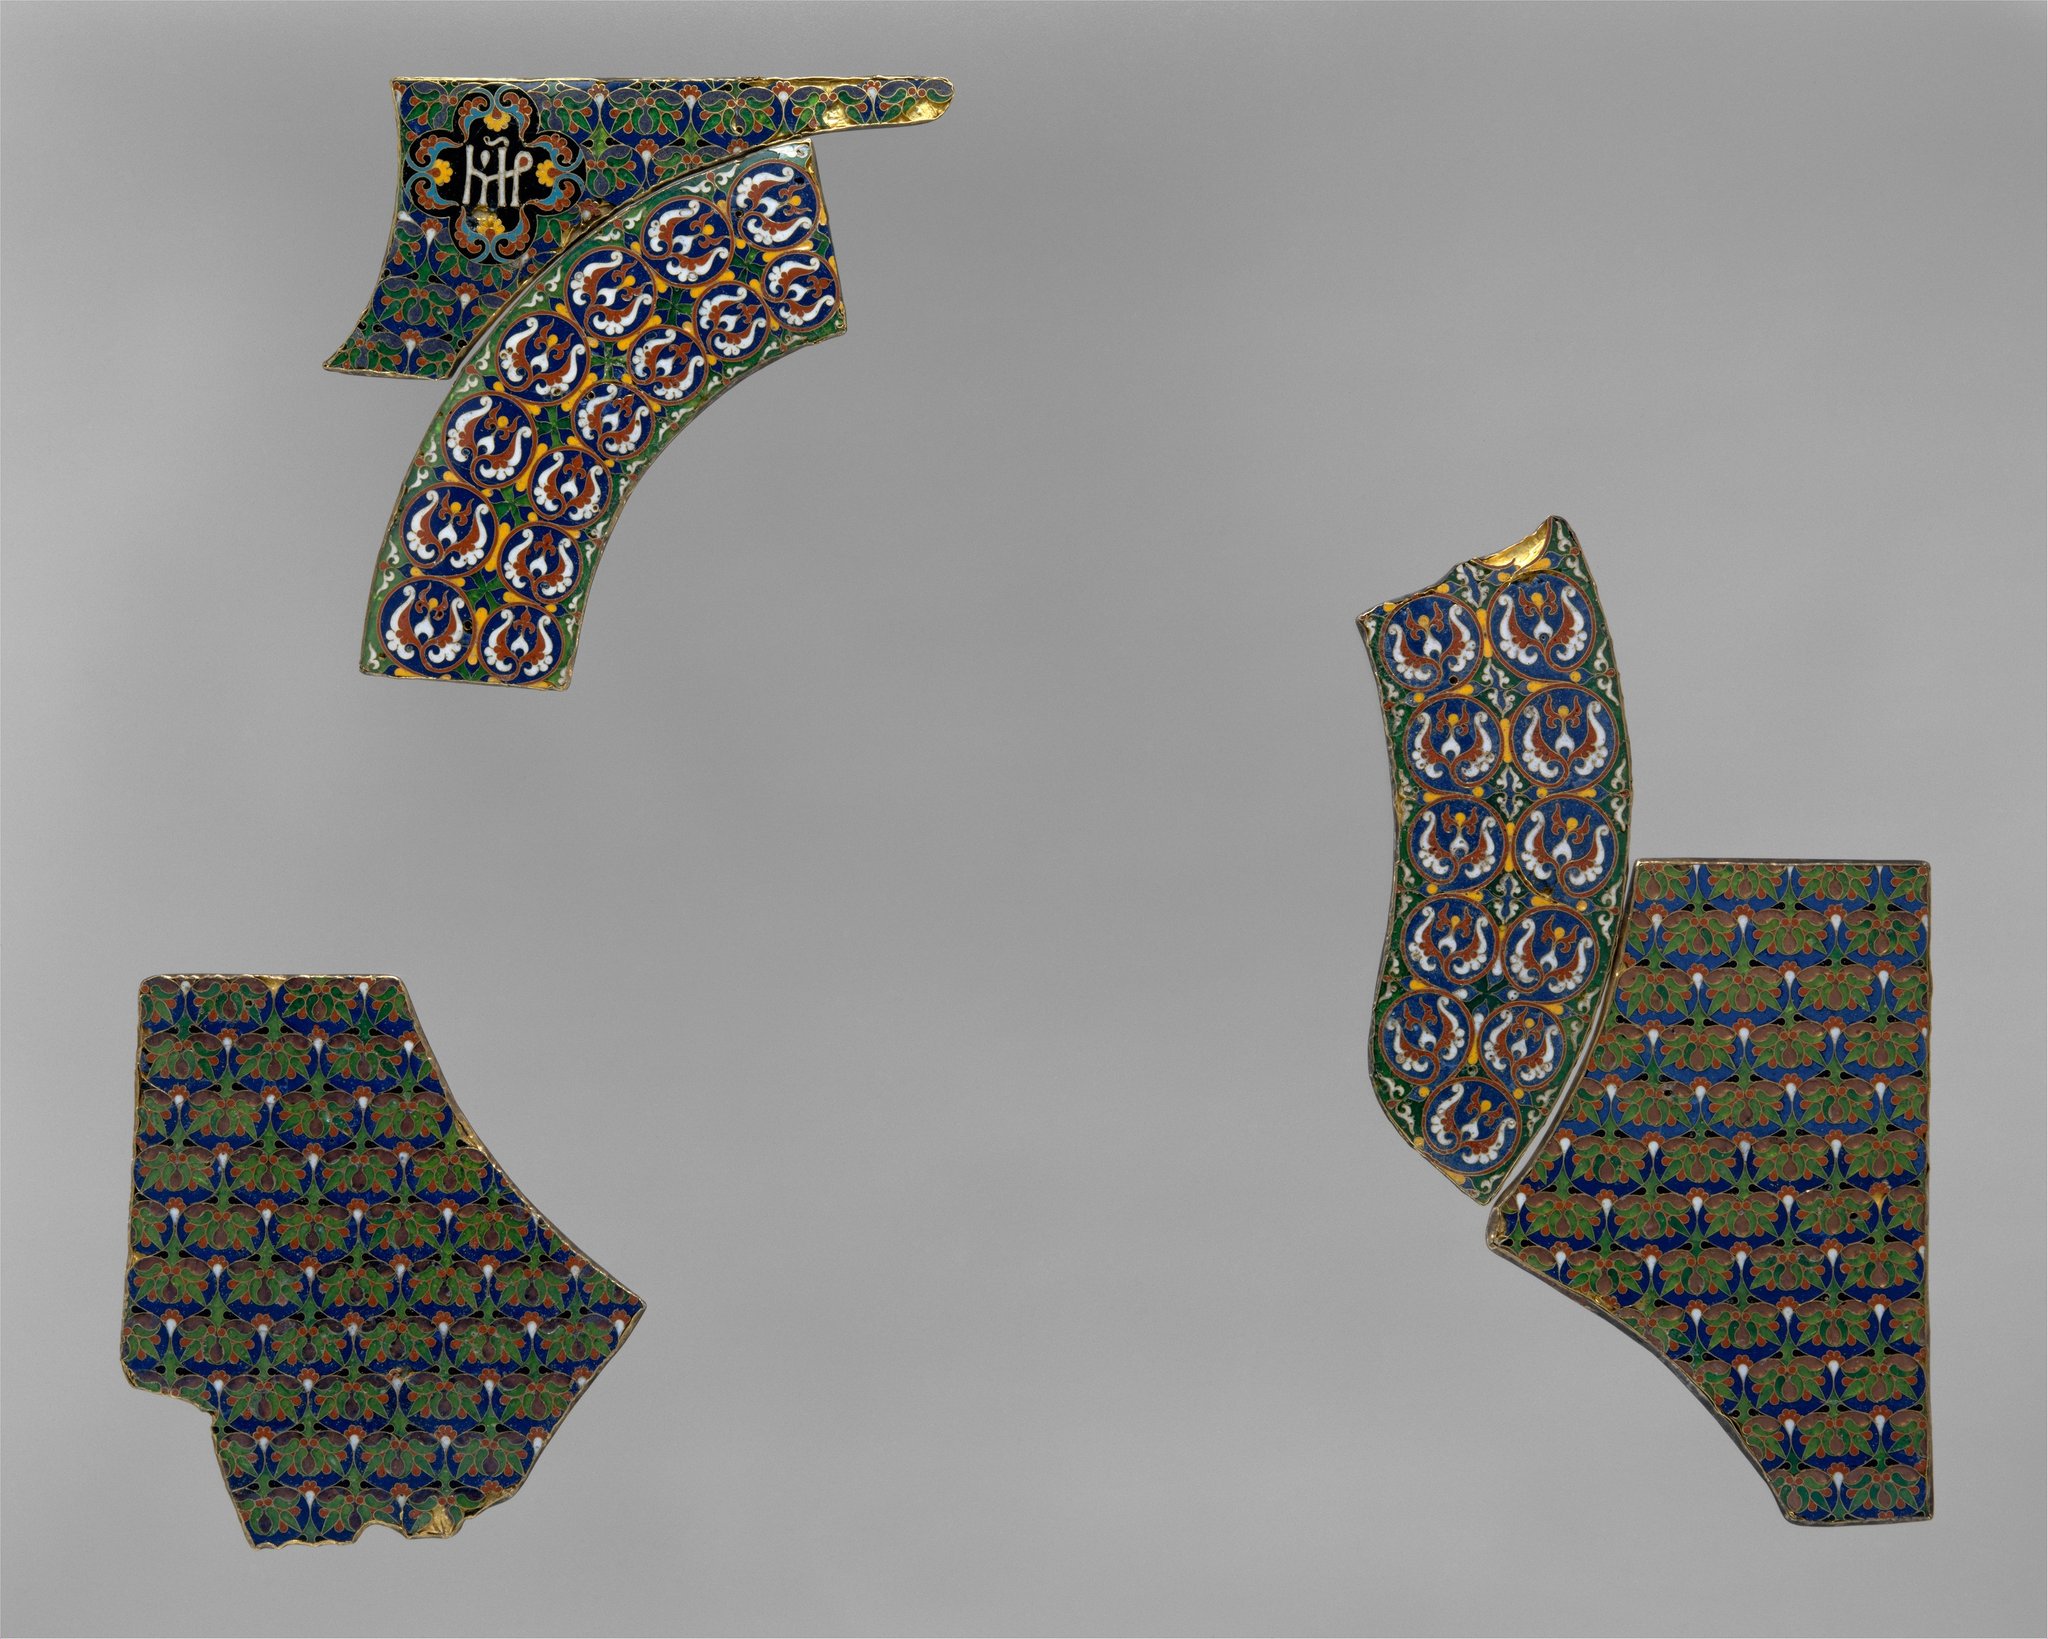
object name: enamel fragment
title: Panel from a Cover for an Icon of the Virgin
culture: byzantine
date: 1100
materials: copper, enamel, gold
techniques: enamel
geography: constantinople